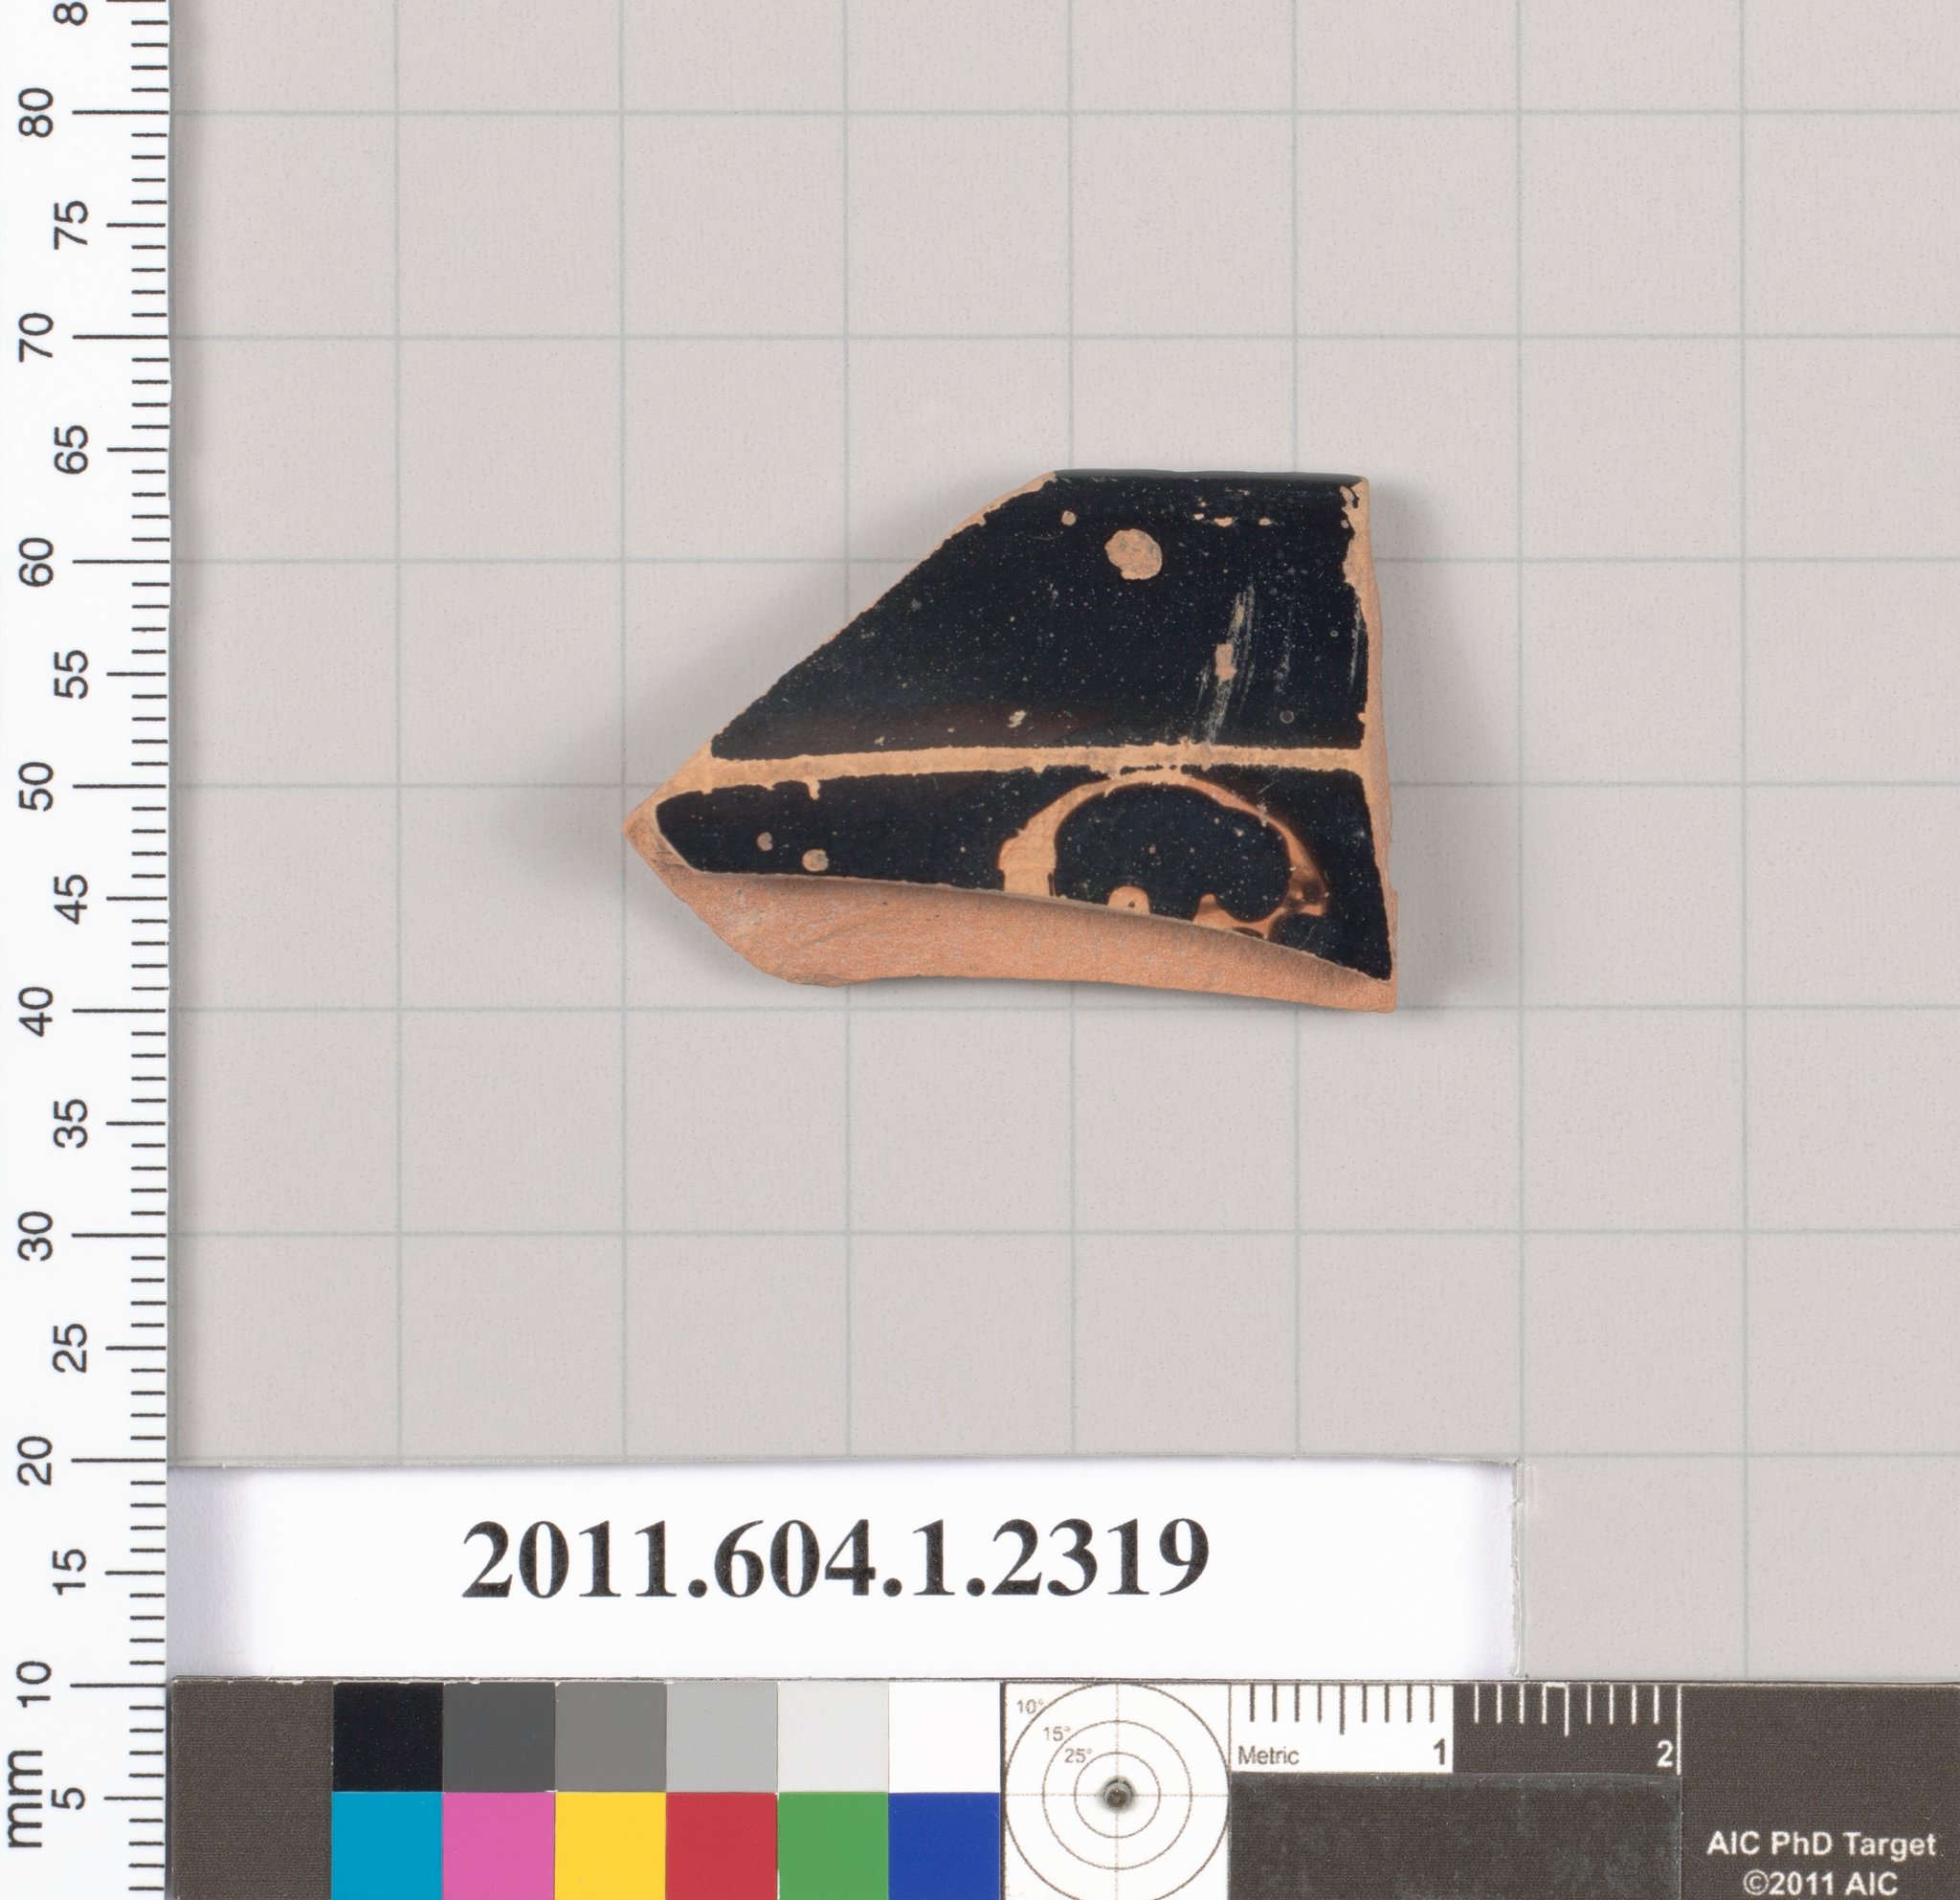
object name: kylix fragment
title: Terracotta rim fragment of a kylix (drinking cup)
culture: greek, attic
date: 475-451 BCE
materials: terracotta